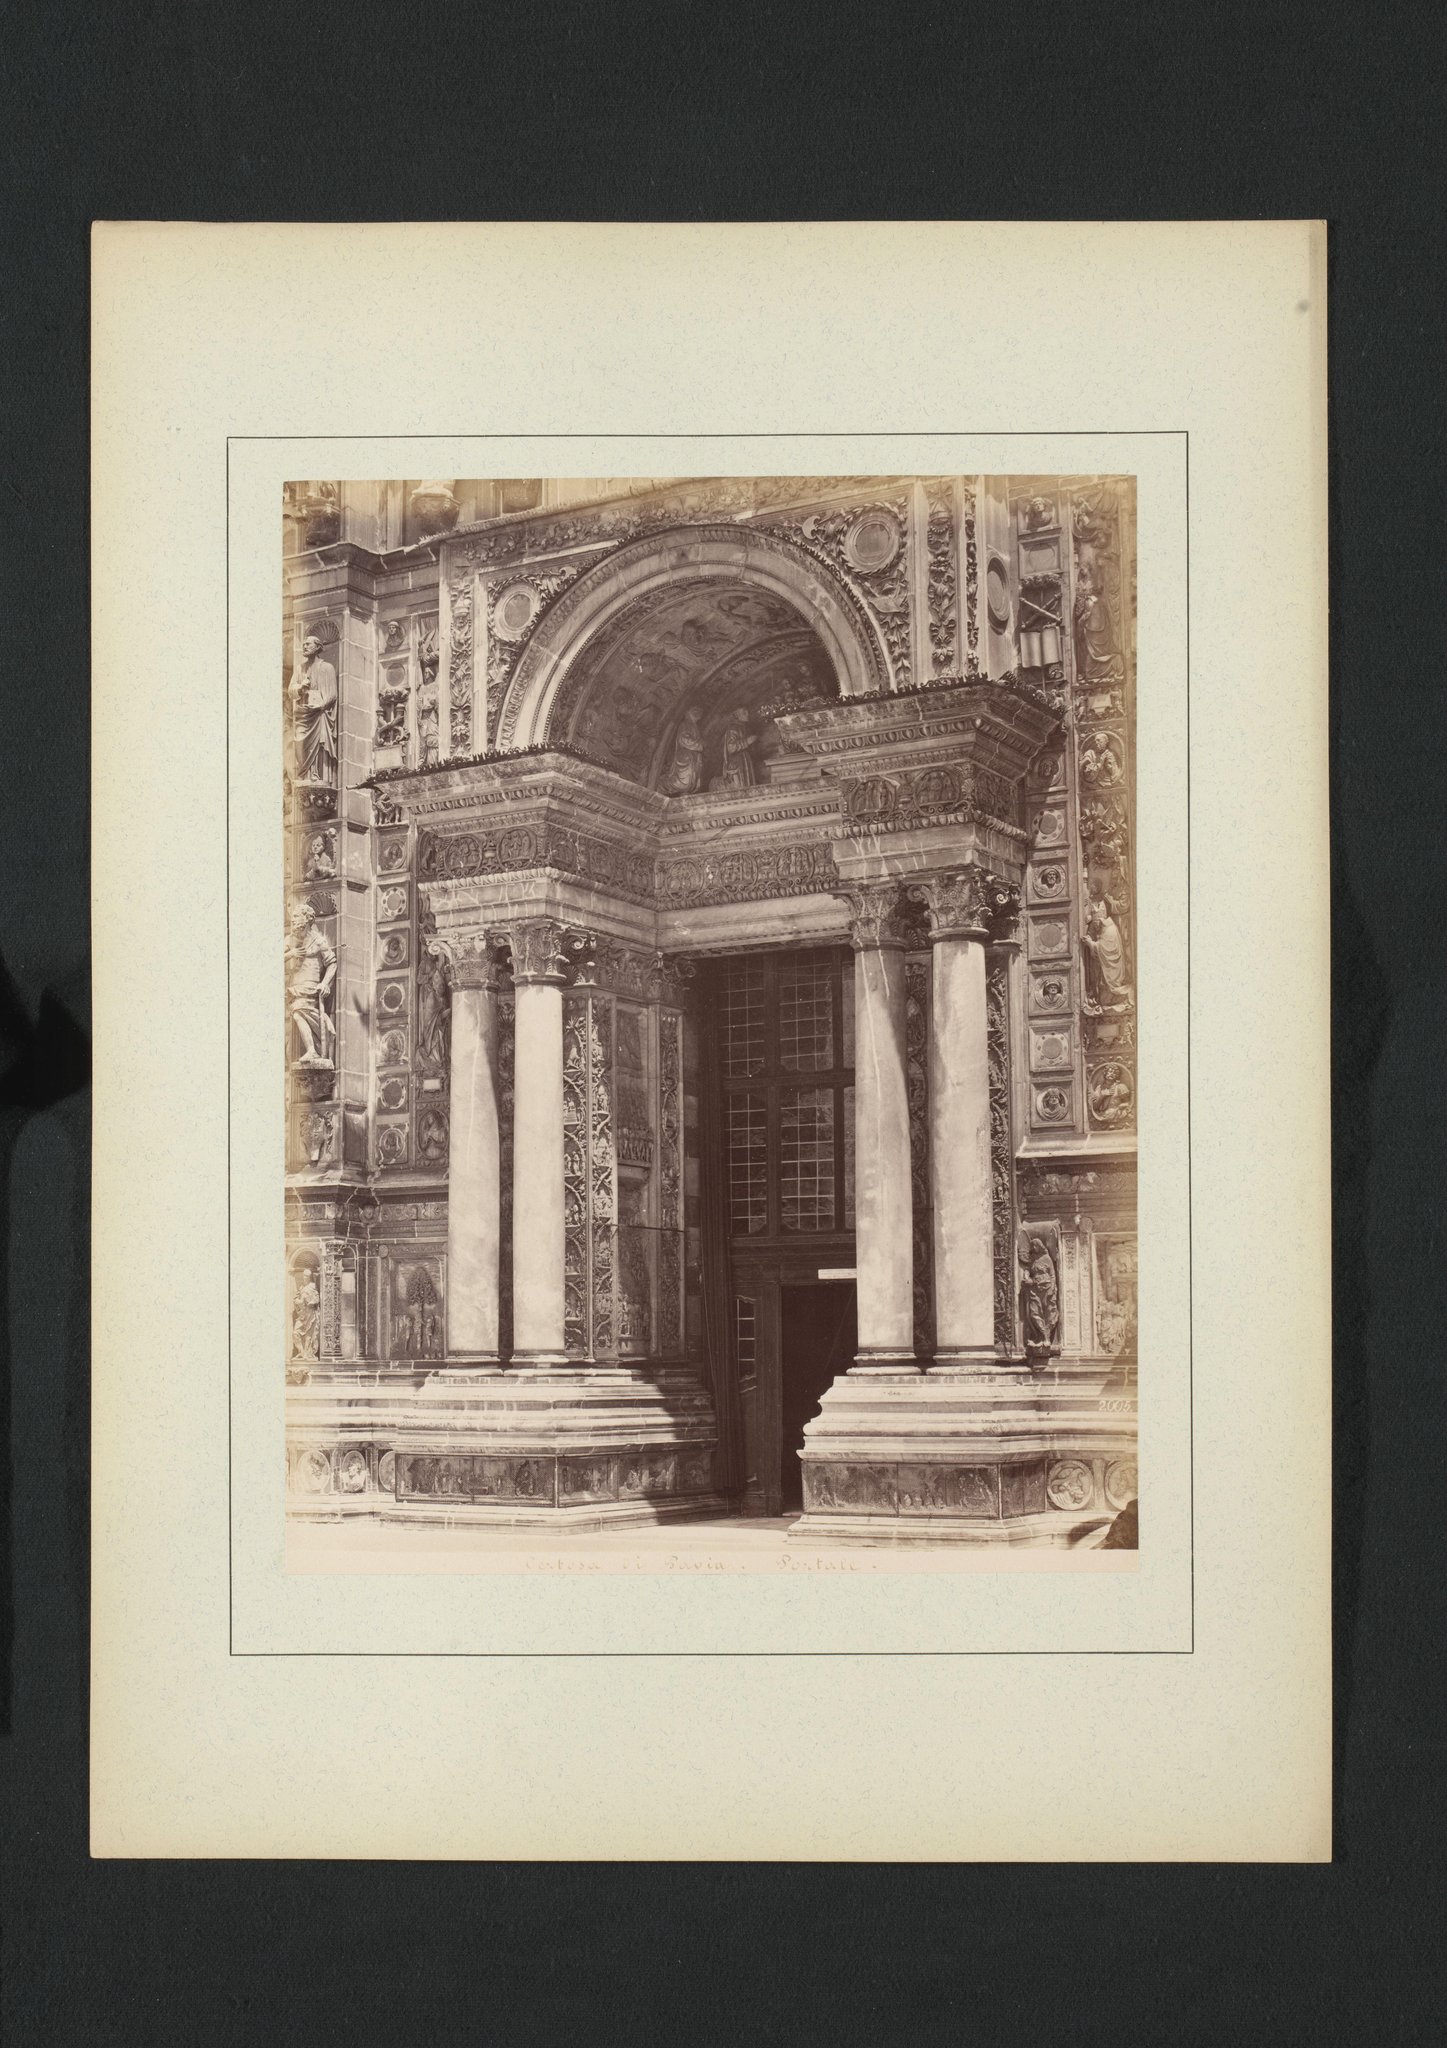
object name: photograph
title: Certosa di Pavia, Portale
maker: alfredo noack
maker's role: fotograaf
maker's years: 1833-1895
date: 1877-1882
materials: cardboard, photographic support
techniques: albumen print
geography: certosa di pavia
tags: abbey, monastery, convent ~ roman catholic church, gate, entrance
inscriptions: number: ‘2005’, inscription: ‘No. 16. Hauptportal.’